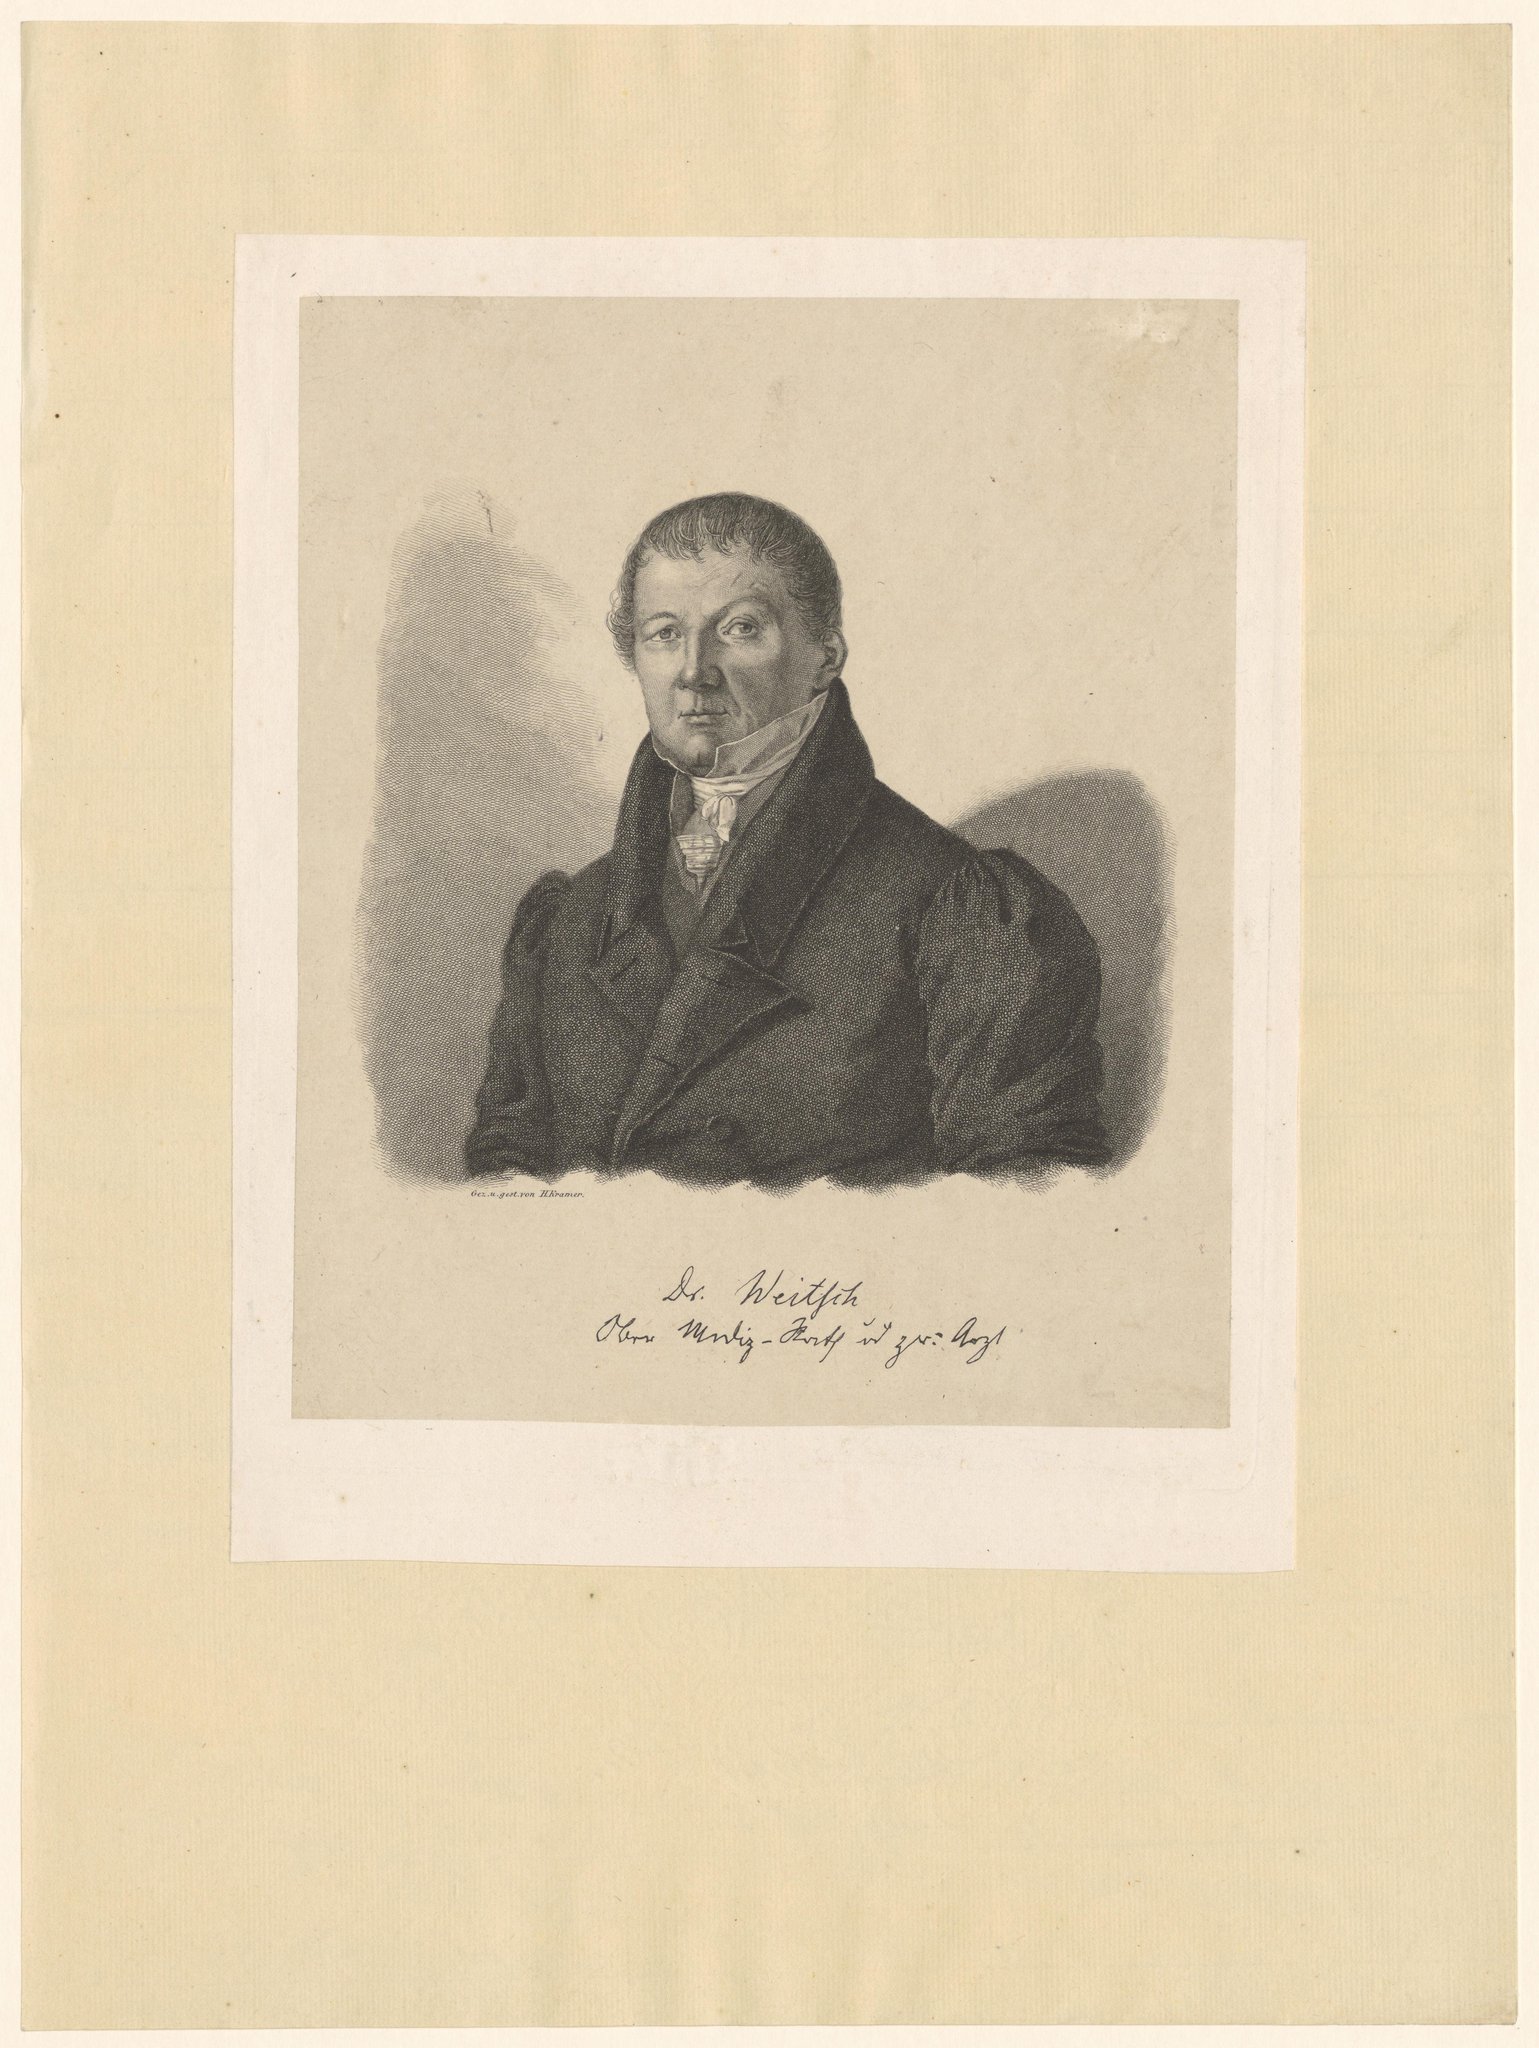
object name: print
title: Portret van Johann Christian Weitsch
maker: hermann kraemer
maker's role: print maker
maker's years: 1808-1886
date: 1818-1886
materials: paper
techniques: etching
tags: historical persons, physician, doctor (+ portrait of scholar, scientist)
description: Een facsimile signatuur in de ondermarge.